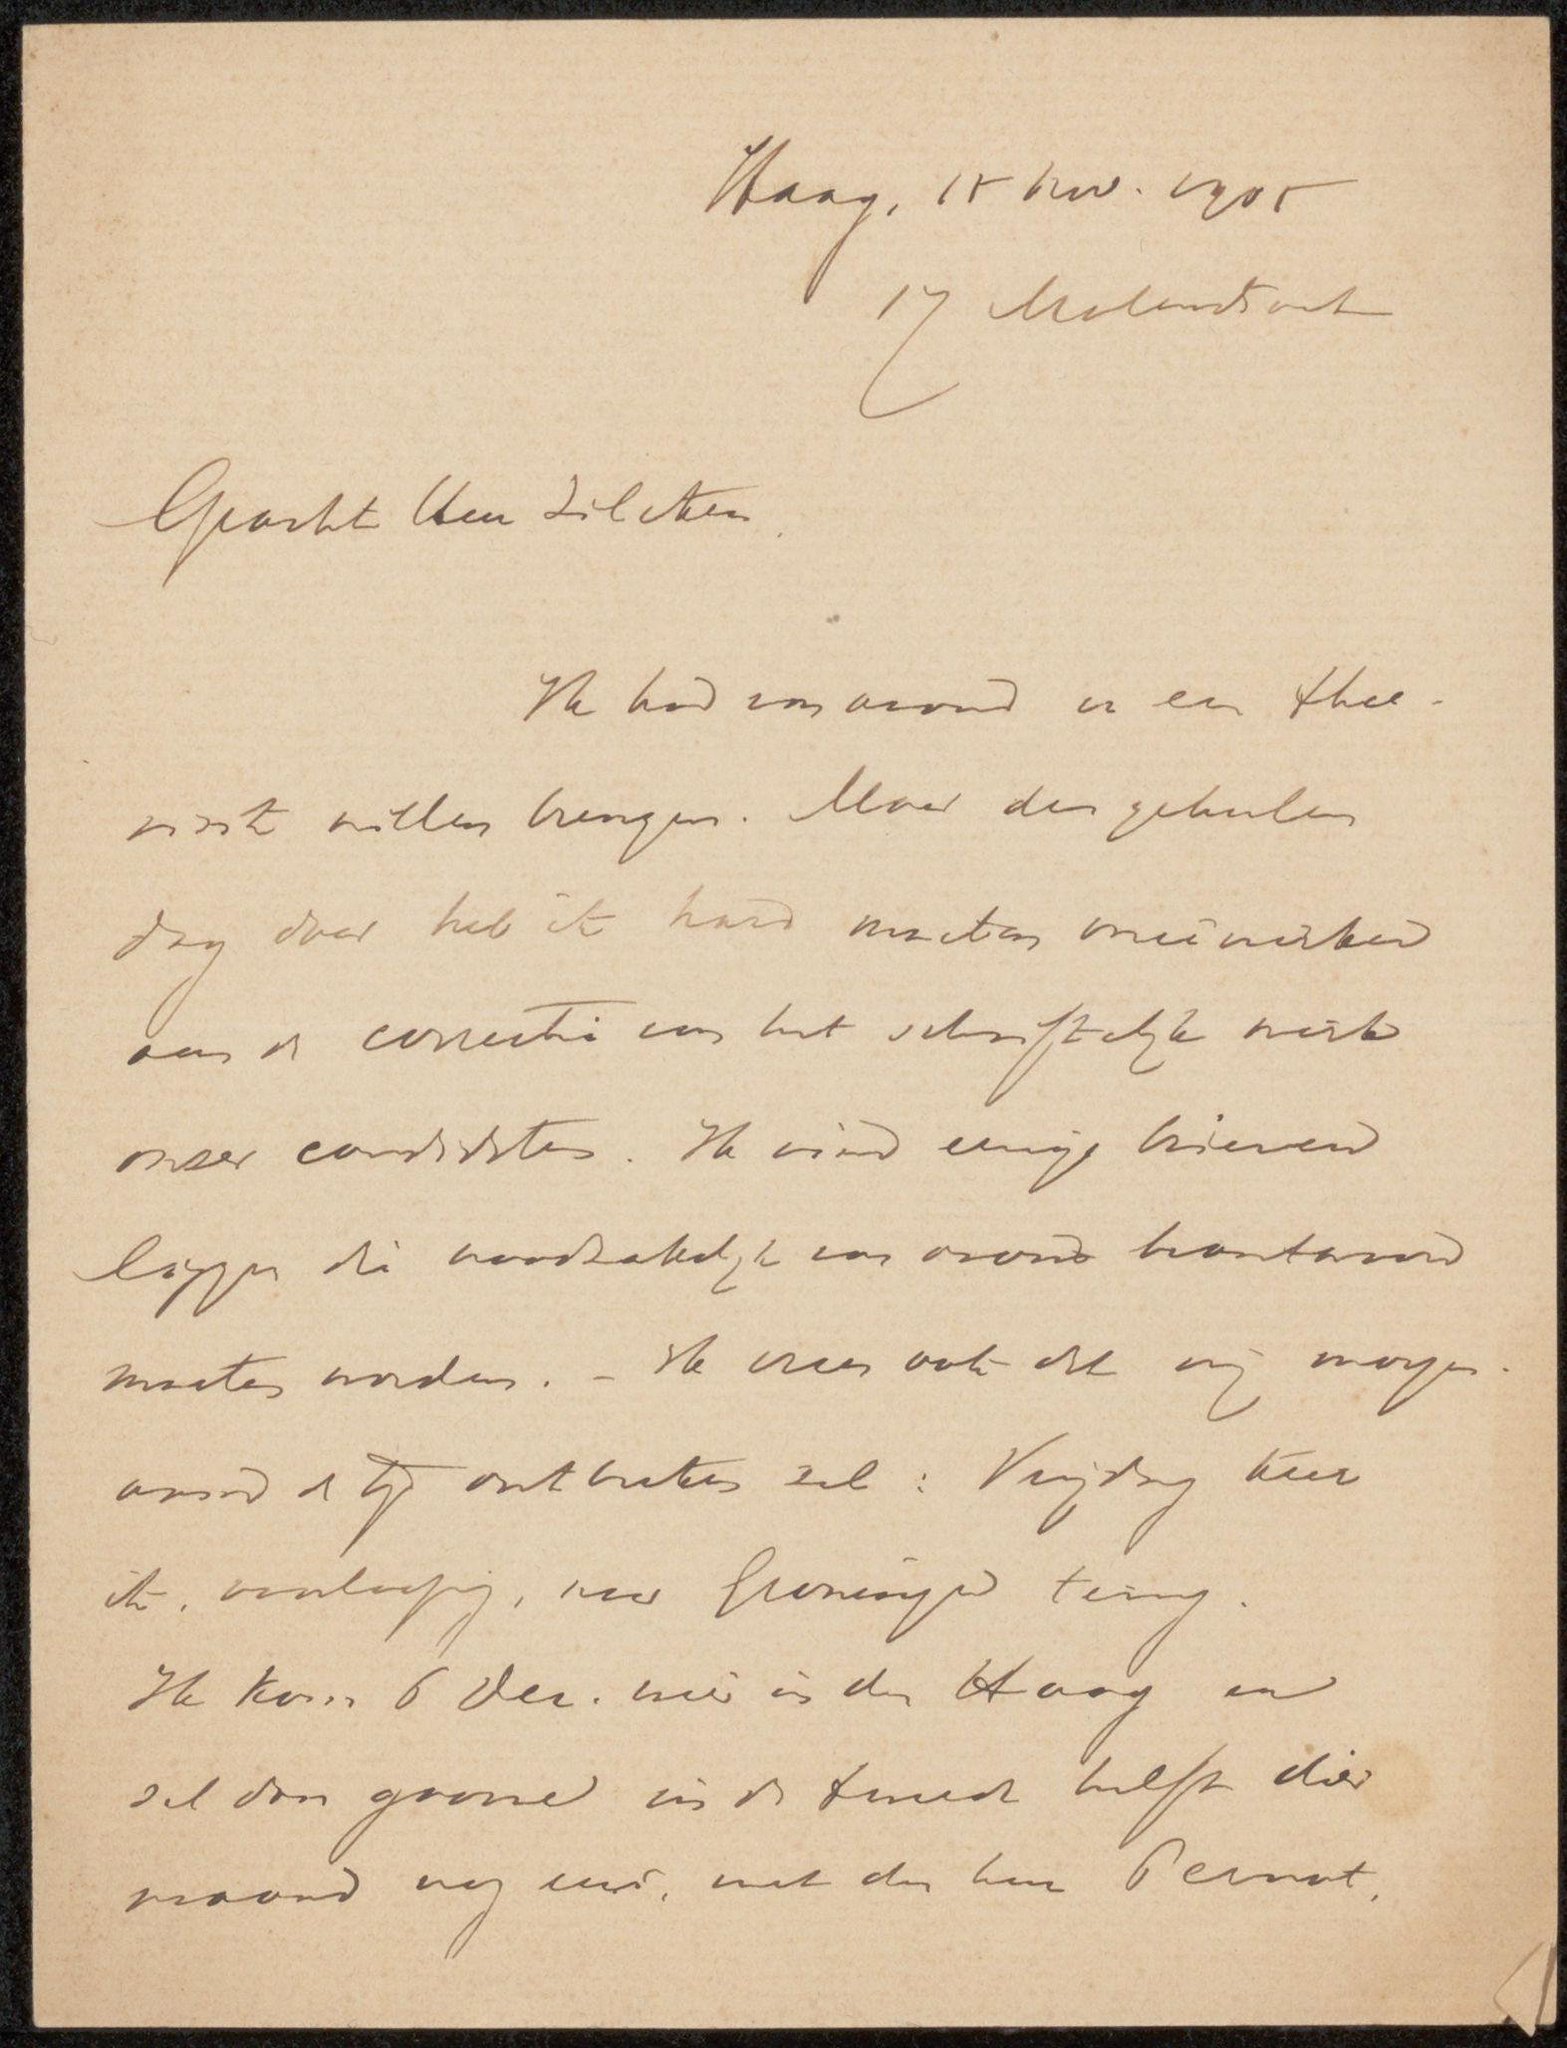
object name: letter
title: Brief aan Philip Zilcken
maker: antonius gerardus van hamel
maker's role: hoogleraar, theoloog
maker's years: 1842-1907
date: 1905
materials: ink, paper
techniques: pen, writing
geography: the hague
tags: maurice pernot, the hague, draughtsman, philip zilcken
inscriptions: collector's mark: ‘RPK’